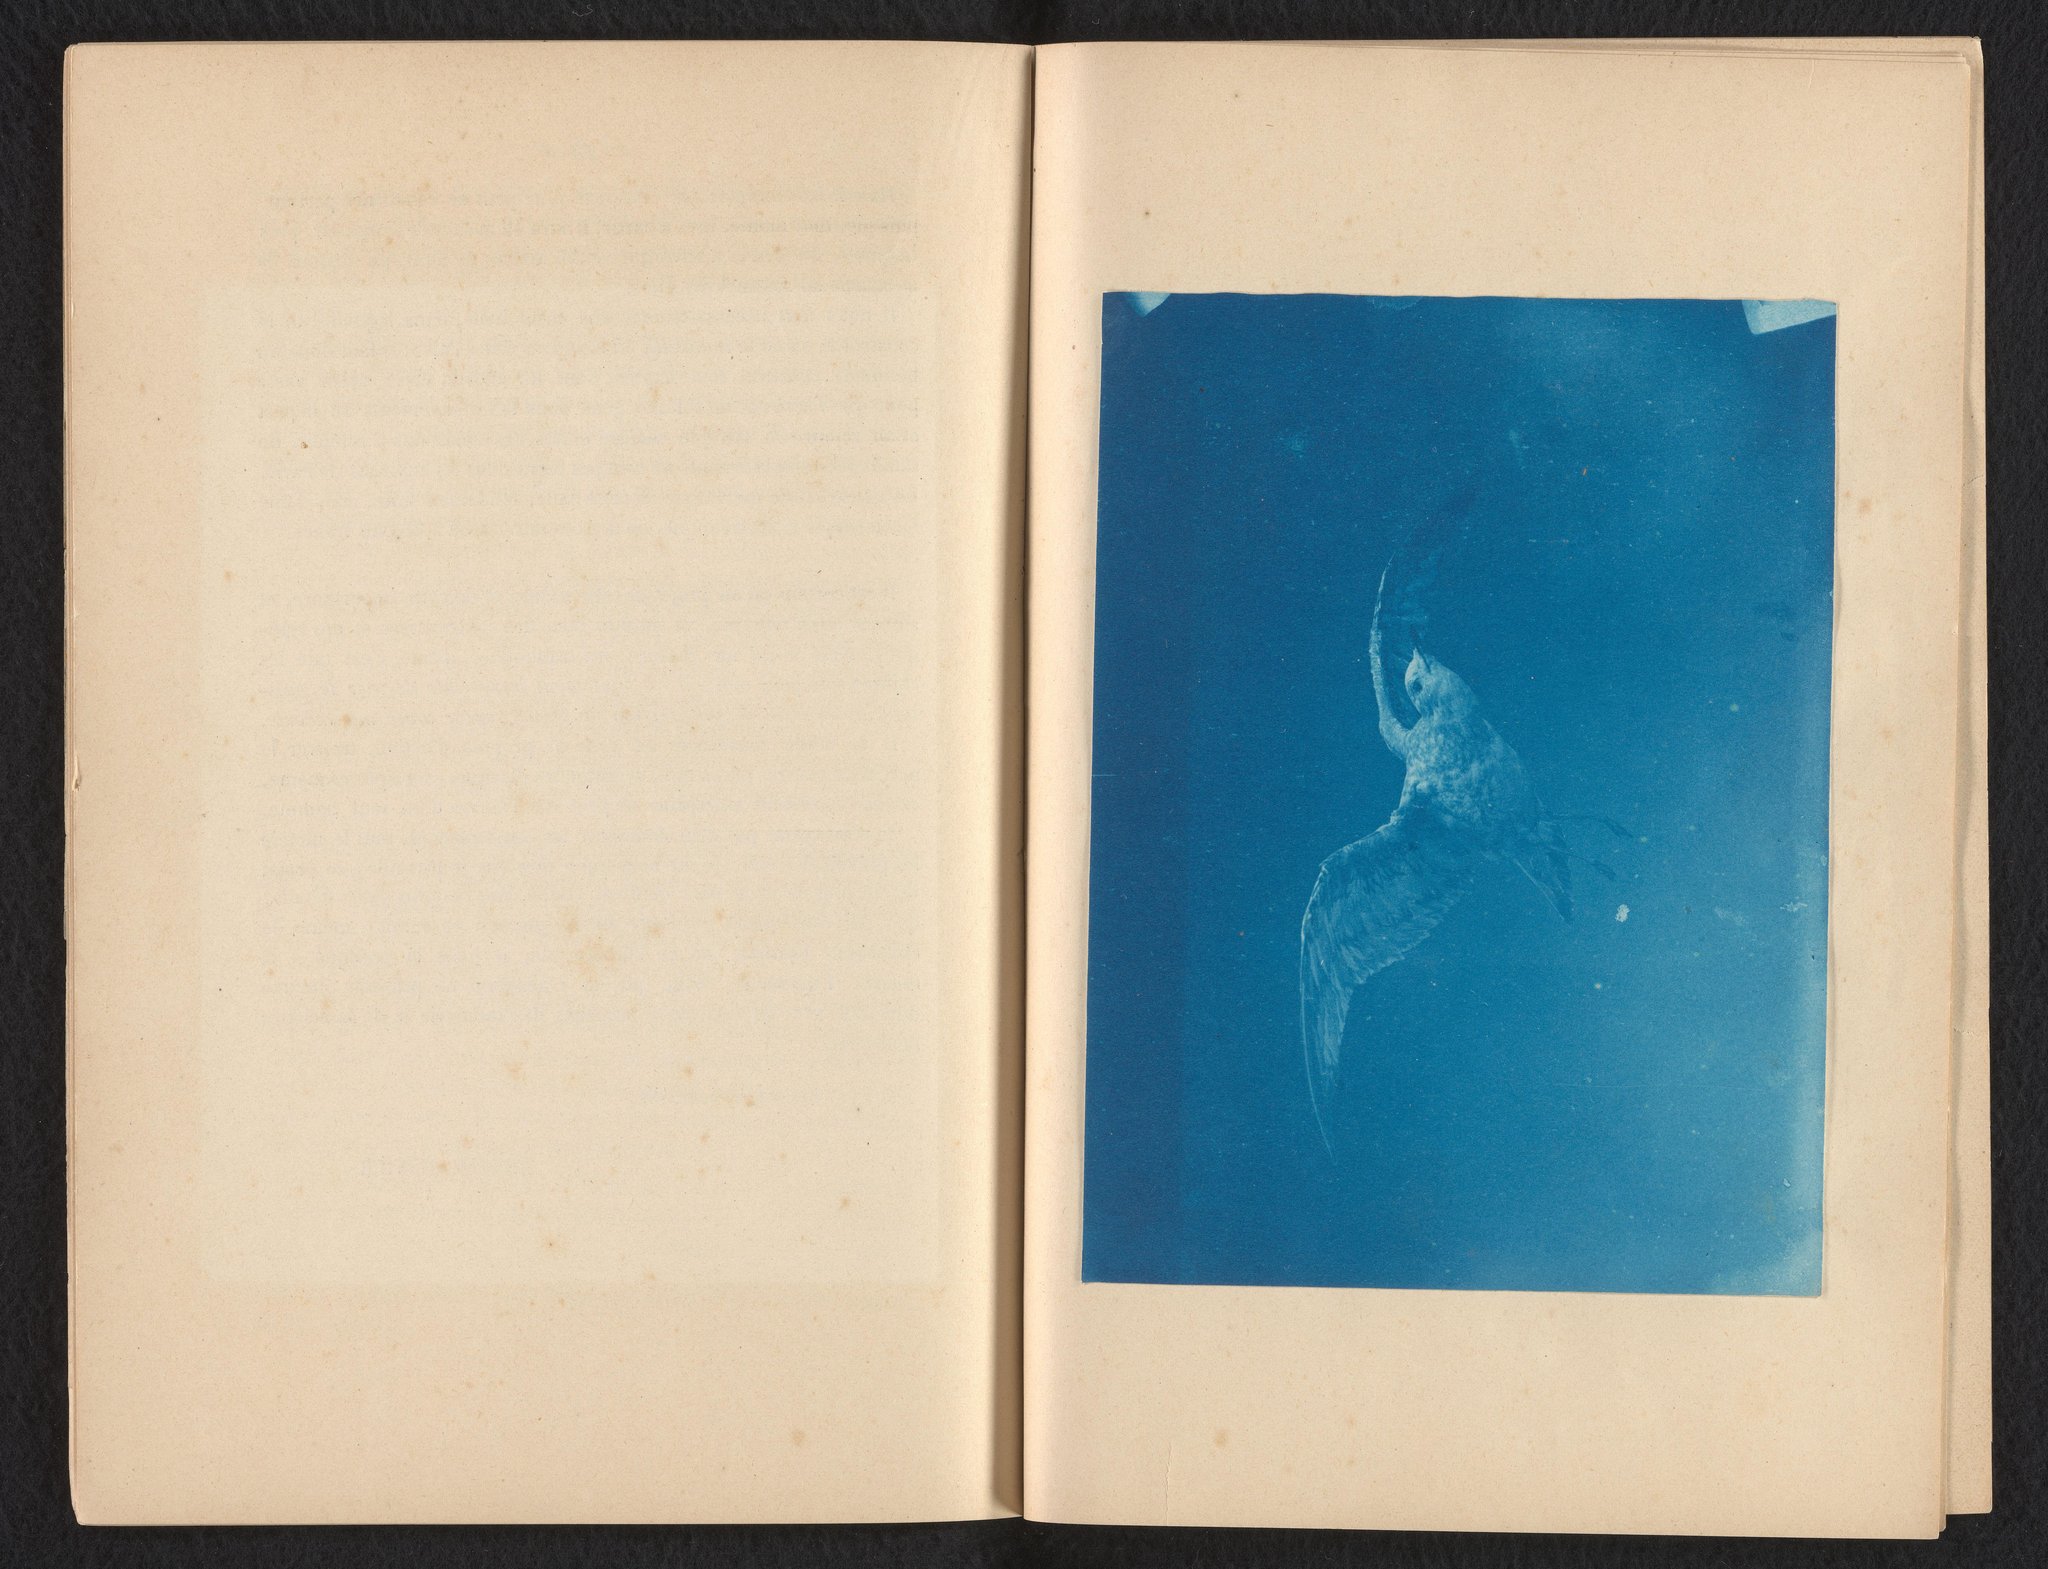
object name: photograph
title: Opgezette vogel met gespreide vleugels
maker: arsène olivier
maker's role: archeoloog, civiel ingenieur, uitvinder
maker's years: 1823-1895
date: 1884-1889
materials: paper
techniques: cyanotype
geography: france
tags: birds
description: Foto op tweede ongenummerde pagina na pagina 25.